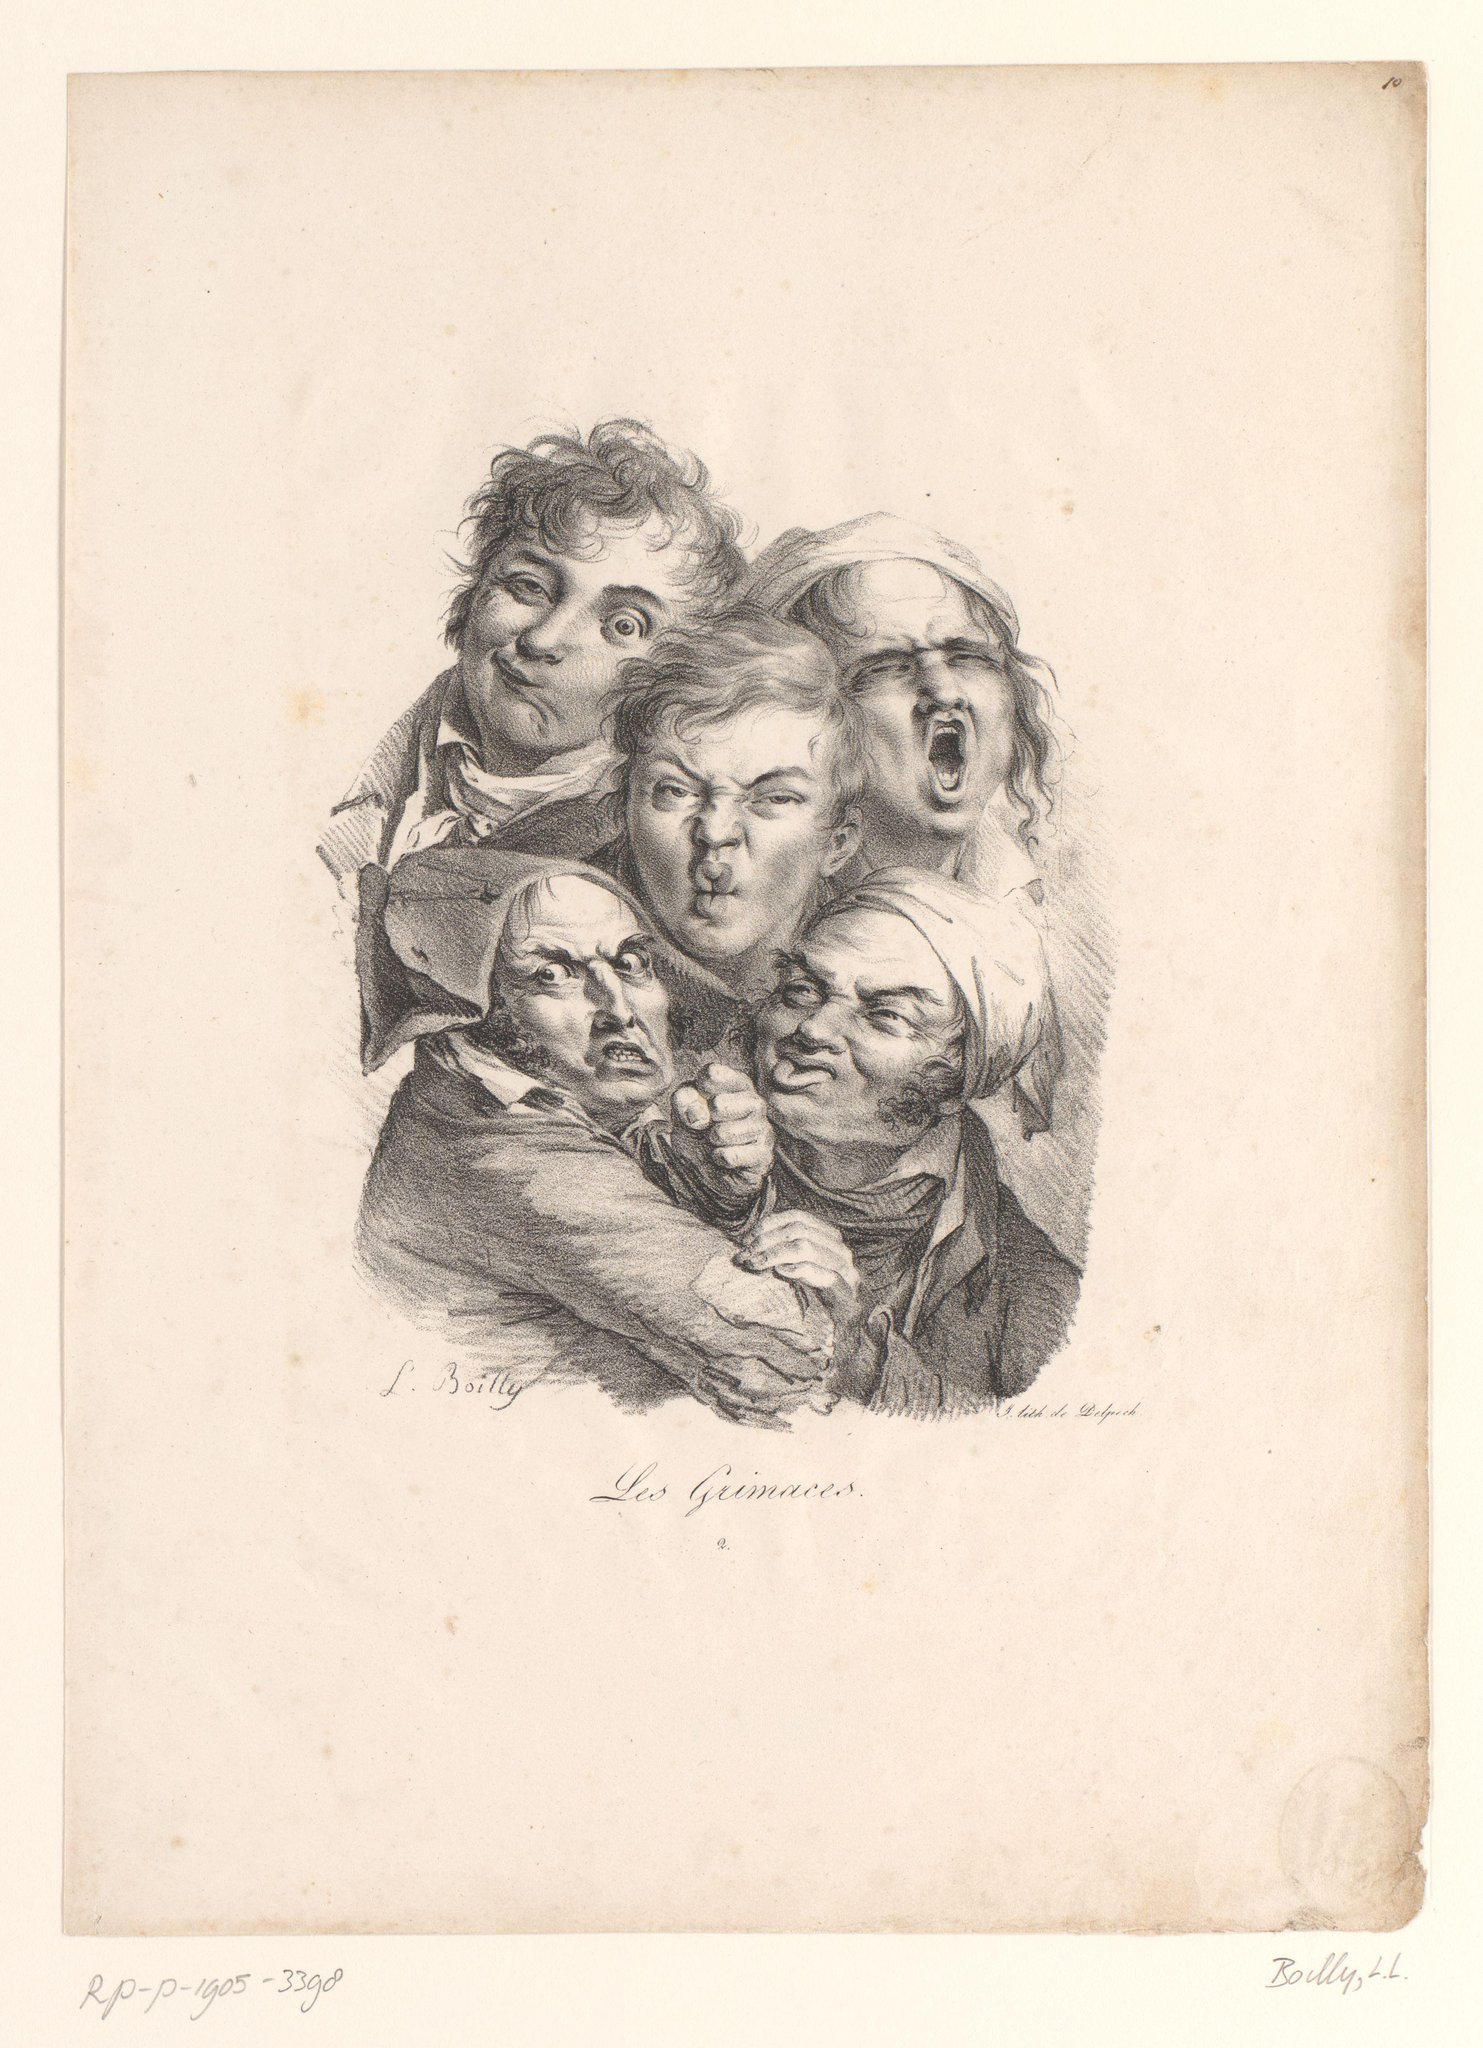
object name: print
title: Gezichten met een grimas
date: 1823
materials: paper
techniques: lithograph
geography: amsterdam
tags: caricatures (human types), morphology of facial expression, dish, plate, saucer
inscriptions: number: ‘10’, collector's mark: Lugt 2228a, stamp: ‘F. Buffa en Zoonen, Amsterdam, Kalverstraat no. 221’